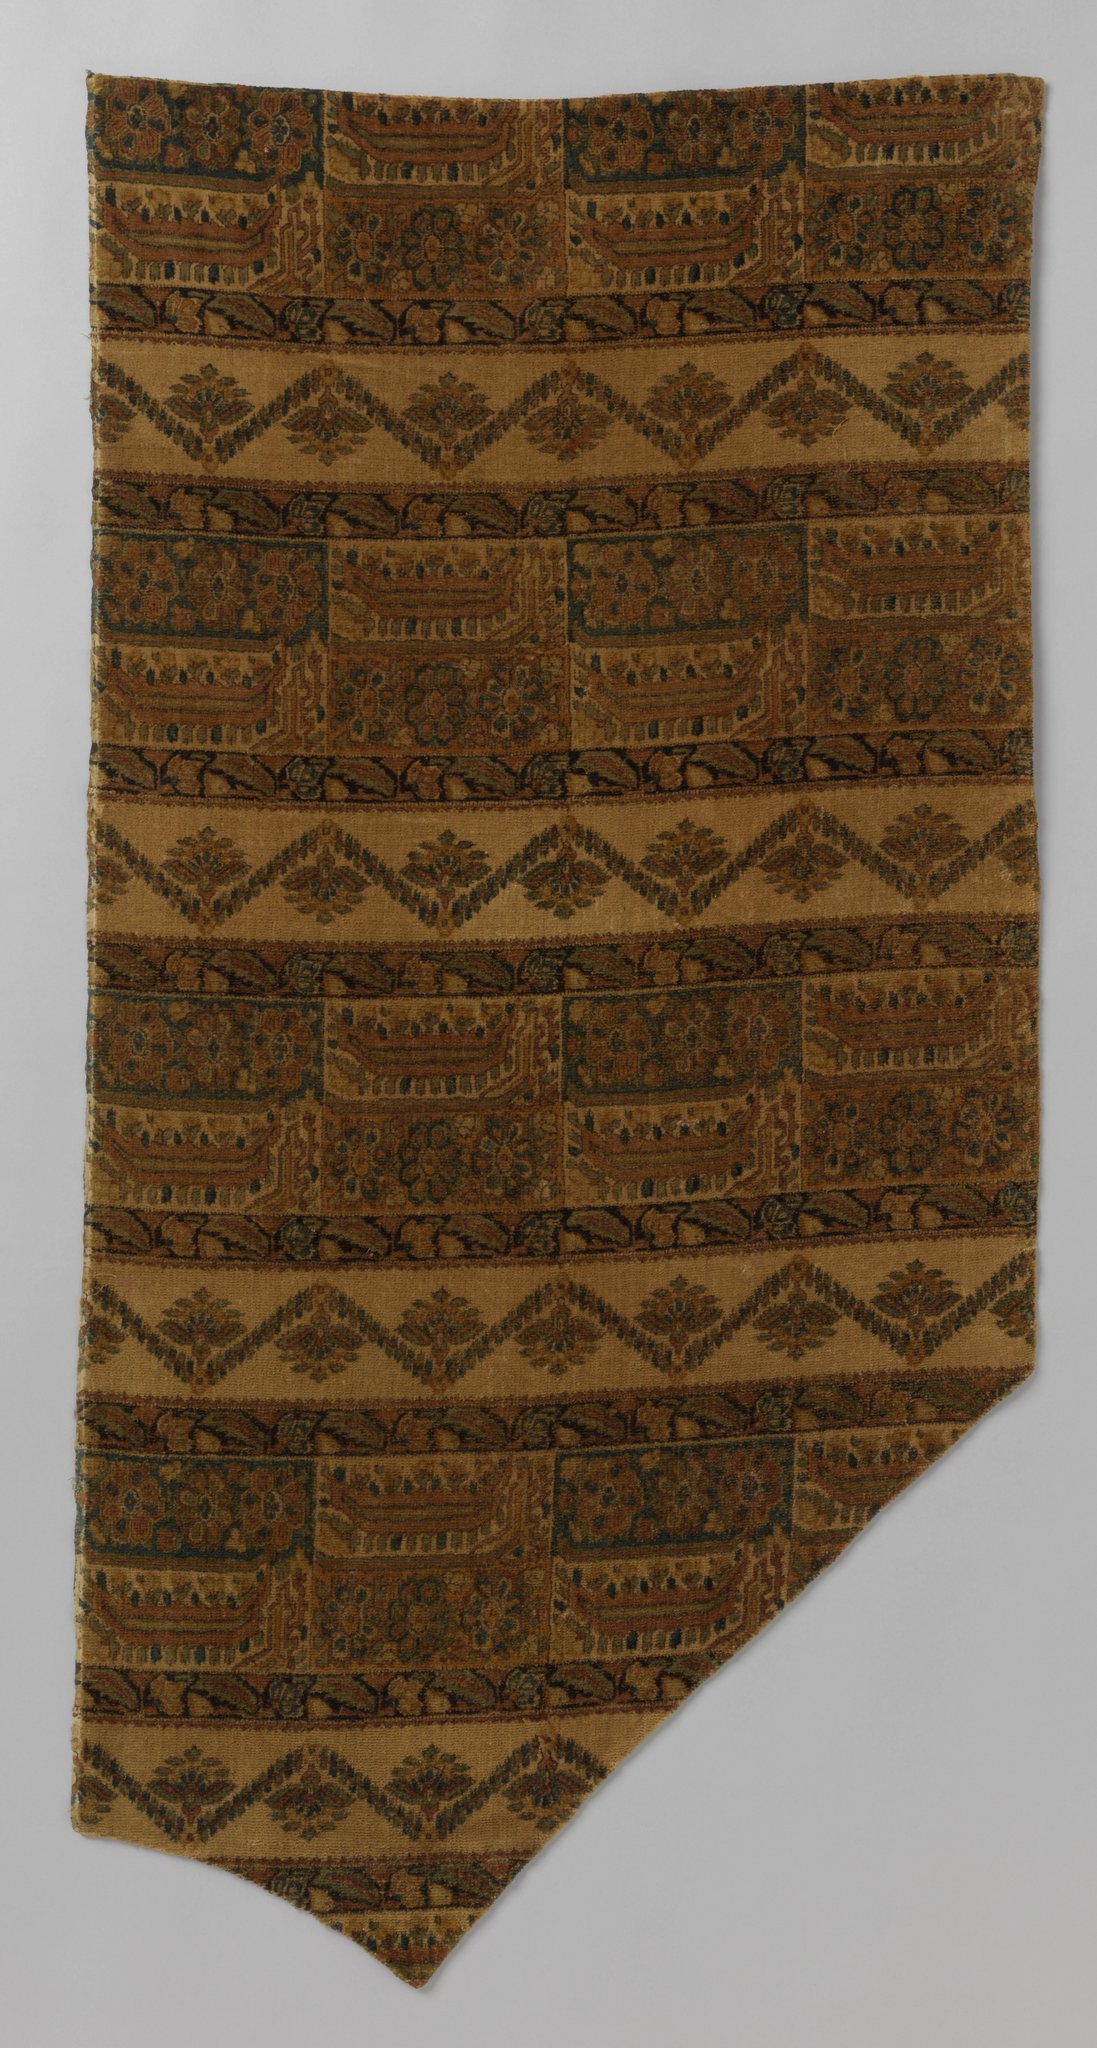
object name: fragment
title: Fragment velours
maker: Anonymous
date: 1845-1855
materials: linen, velvet, wool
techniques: printing, weave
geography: netherlands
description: Fragment velours, geel-bruin fond bedrukt met Kashmirmotieven in bruin, groen, zwart en blauw.